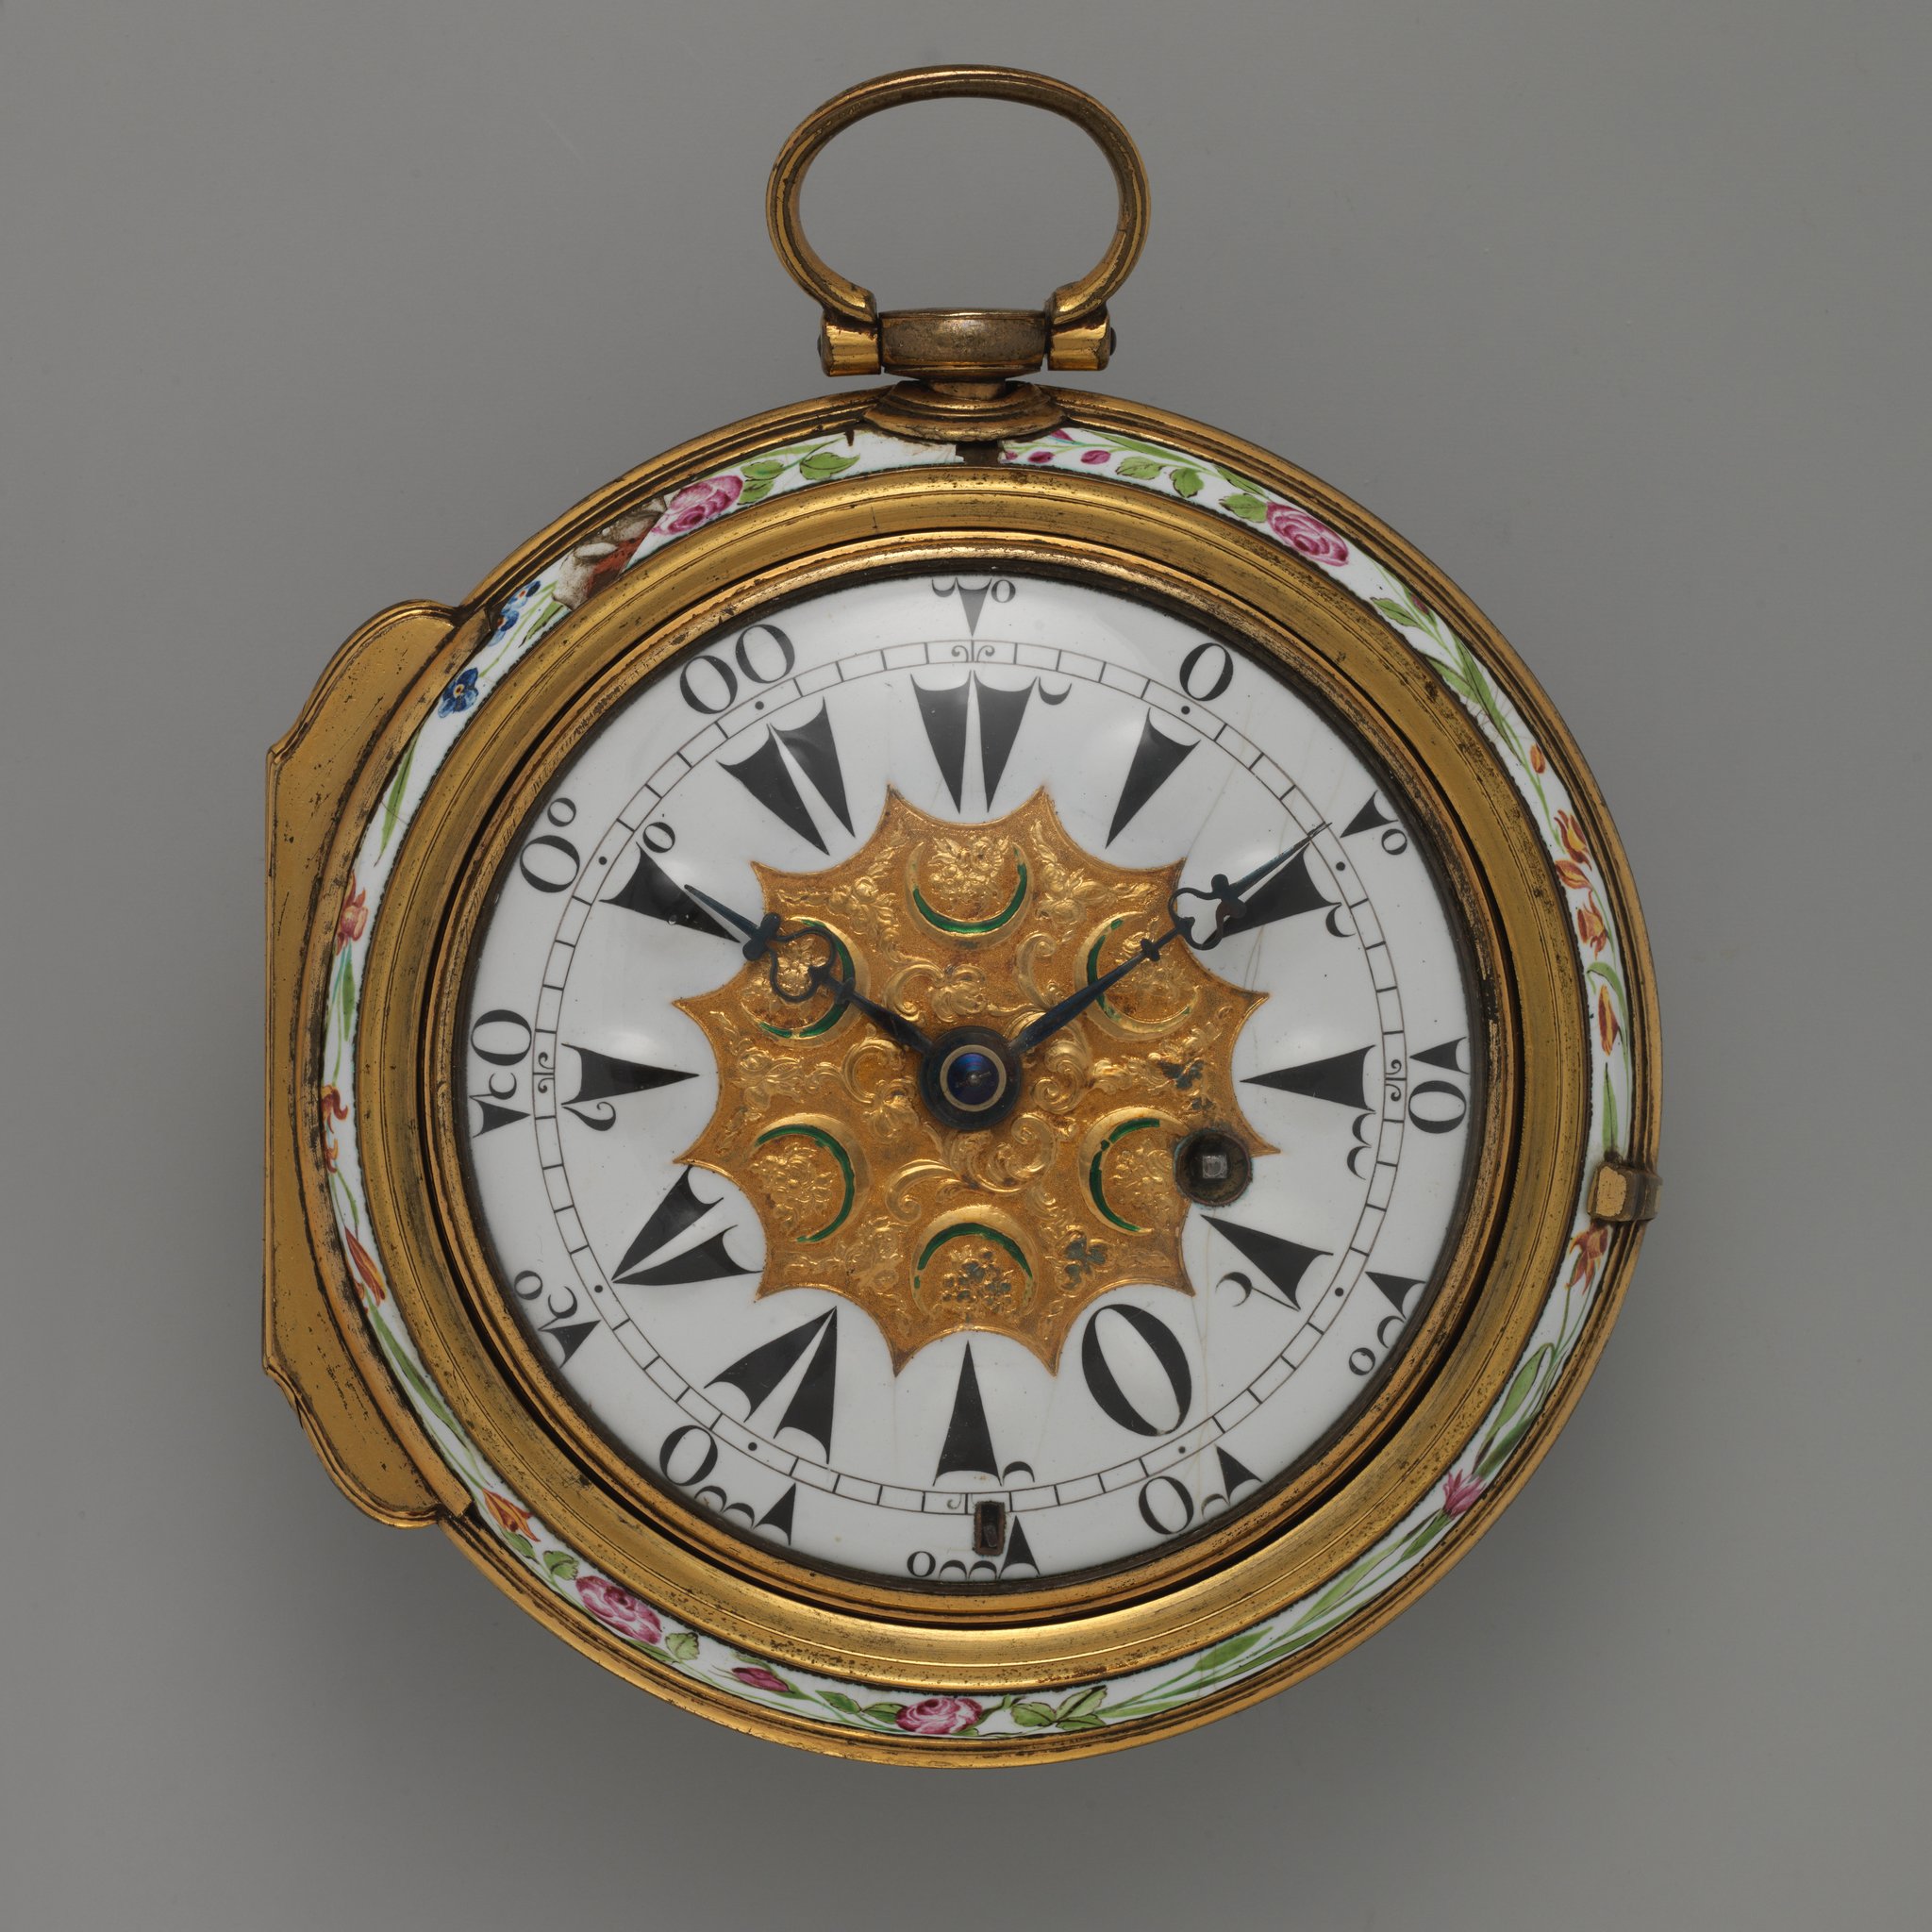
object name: clock watch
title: Clock-watch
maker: firm of marwick, markham and recordon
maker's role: maker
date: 1740-1760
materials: enamel, gilt, metal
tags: roses